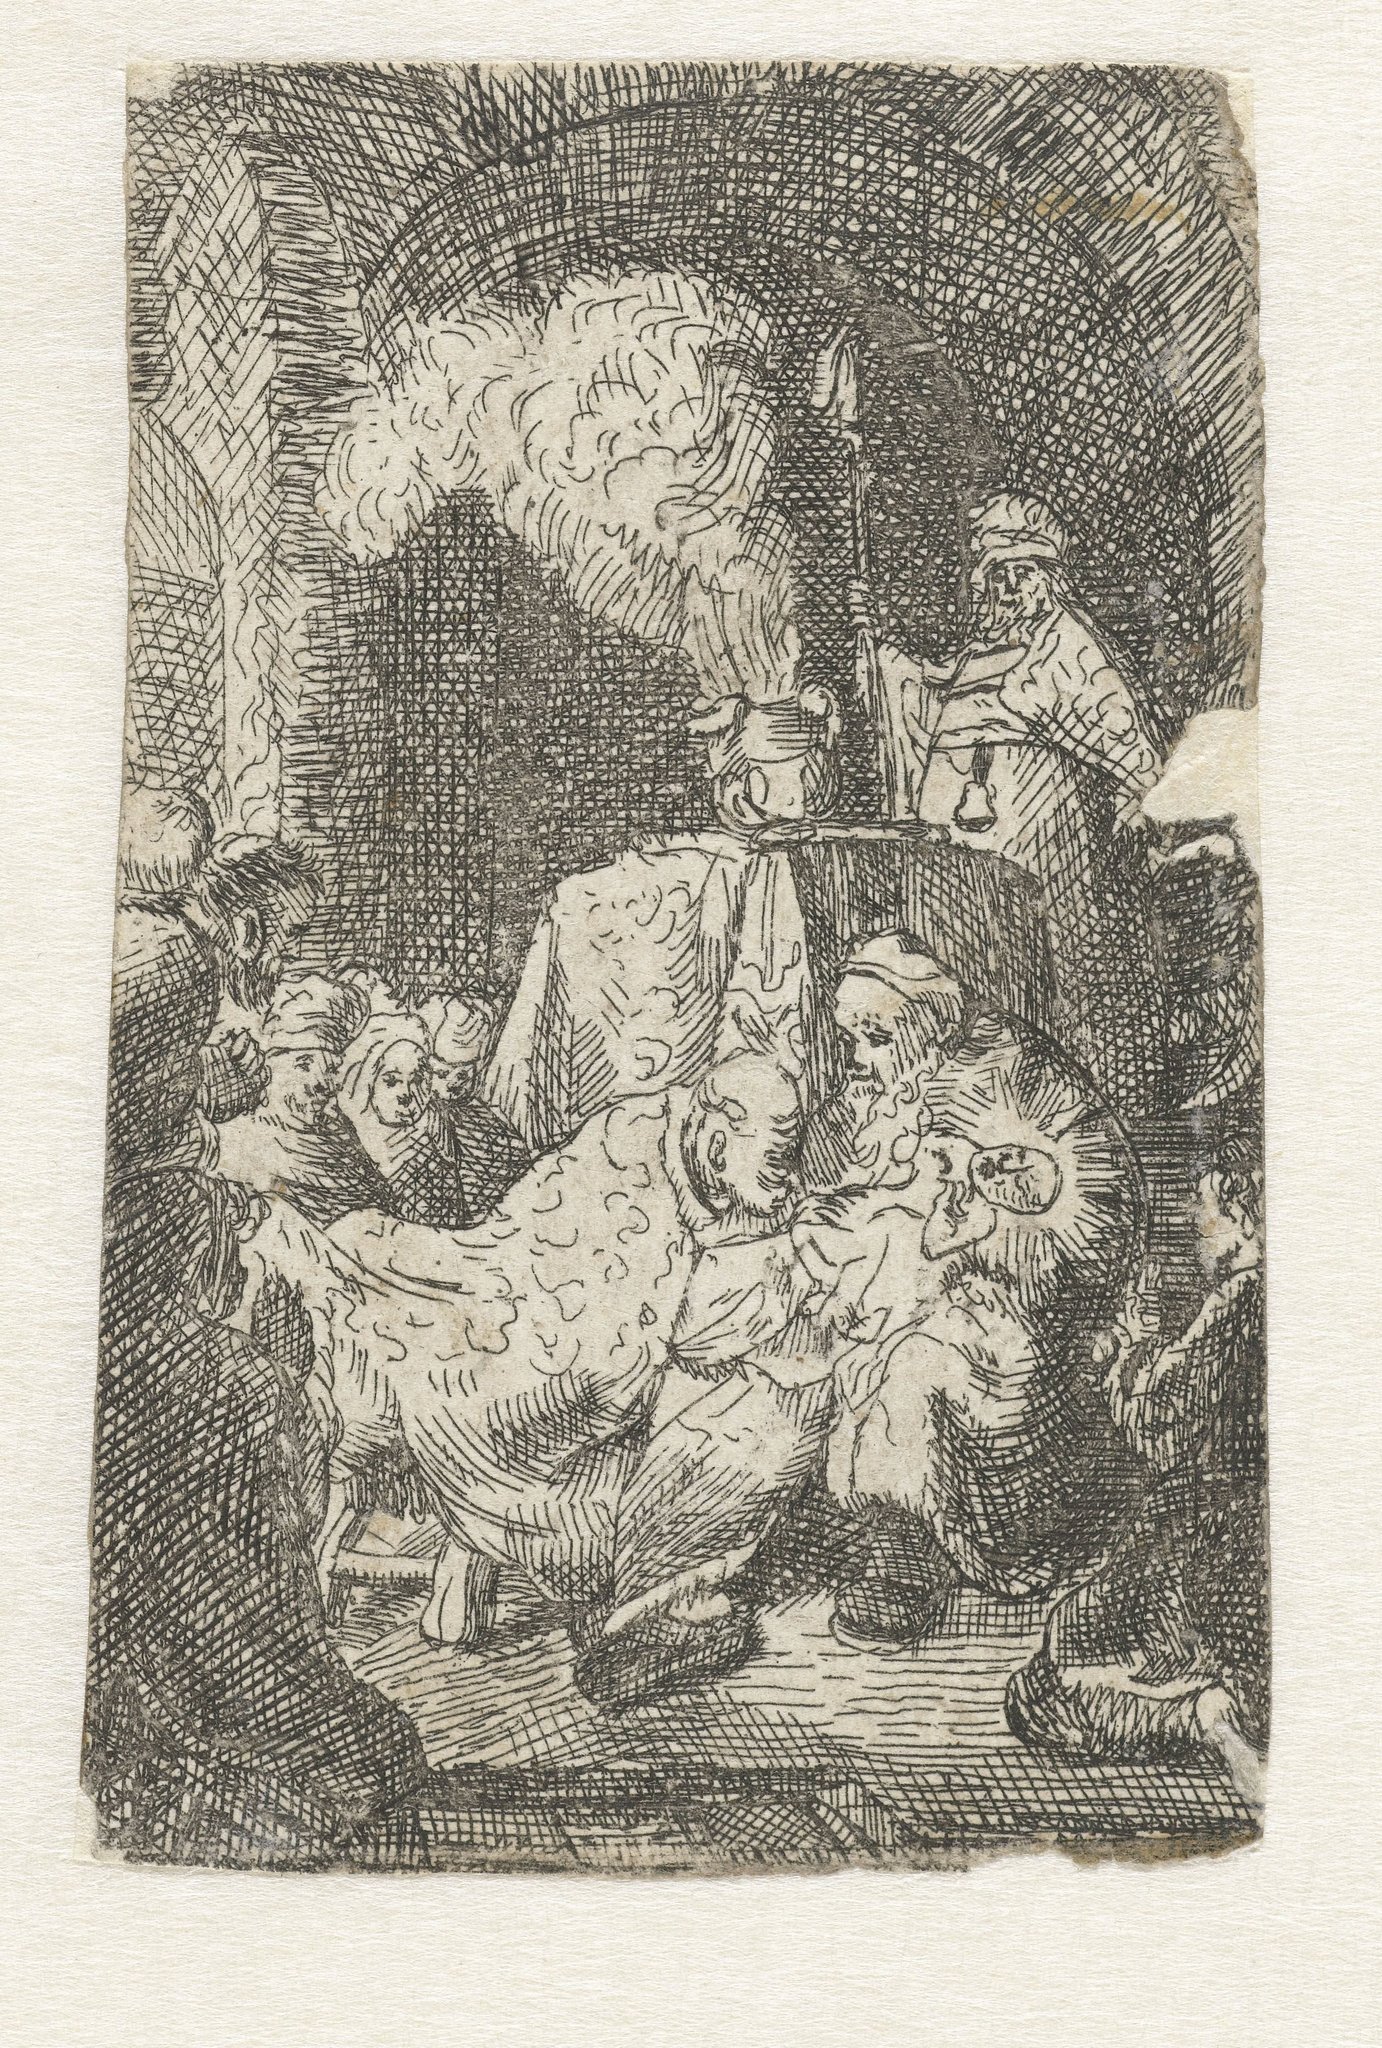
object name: print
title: The circumcision: small plate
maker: Anonymous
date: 1630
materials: paper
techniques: etching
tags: story of noah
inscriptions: collector's mark: Lugt 2228, collector's mark: Lugt 2760